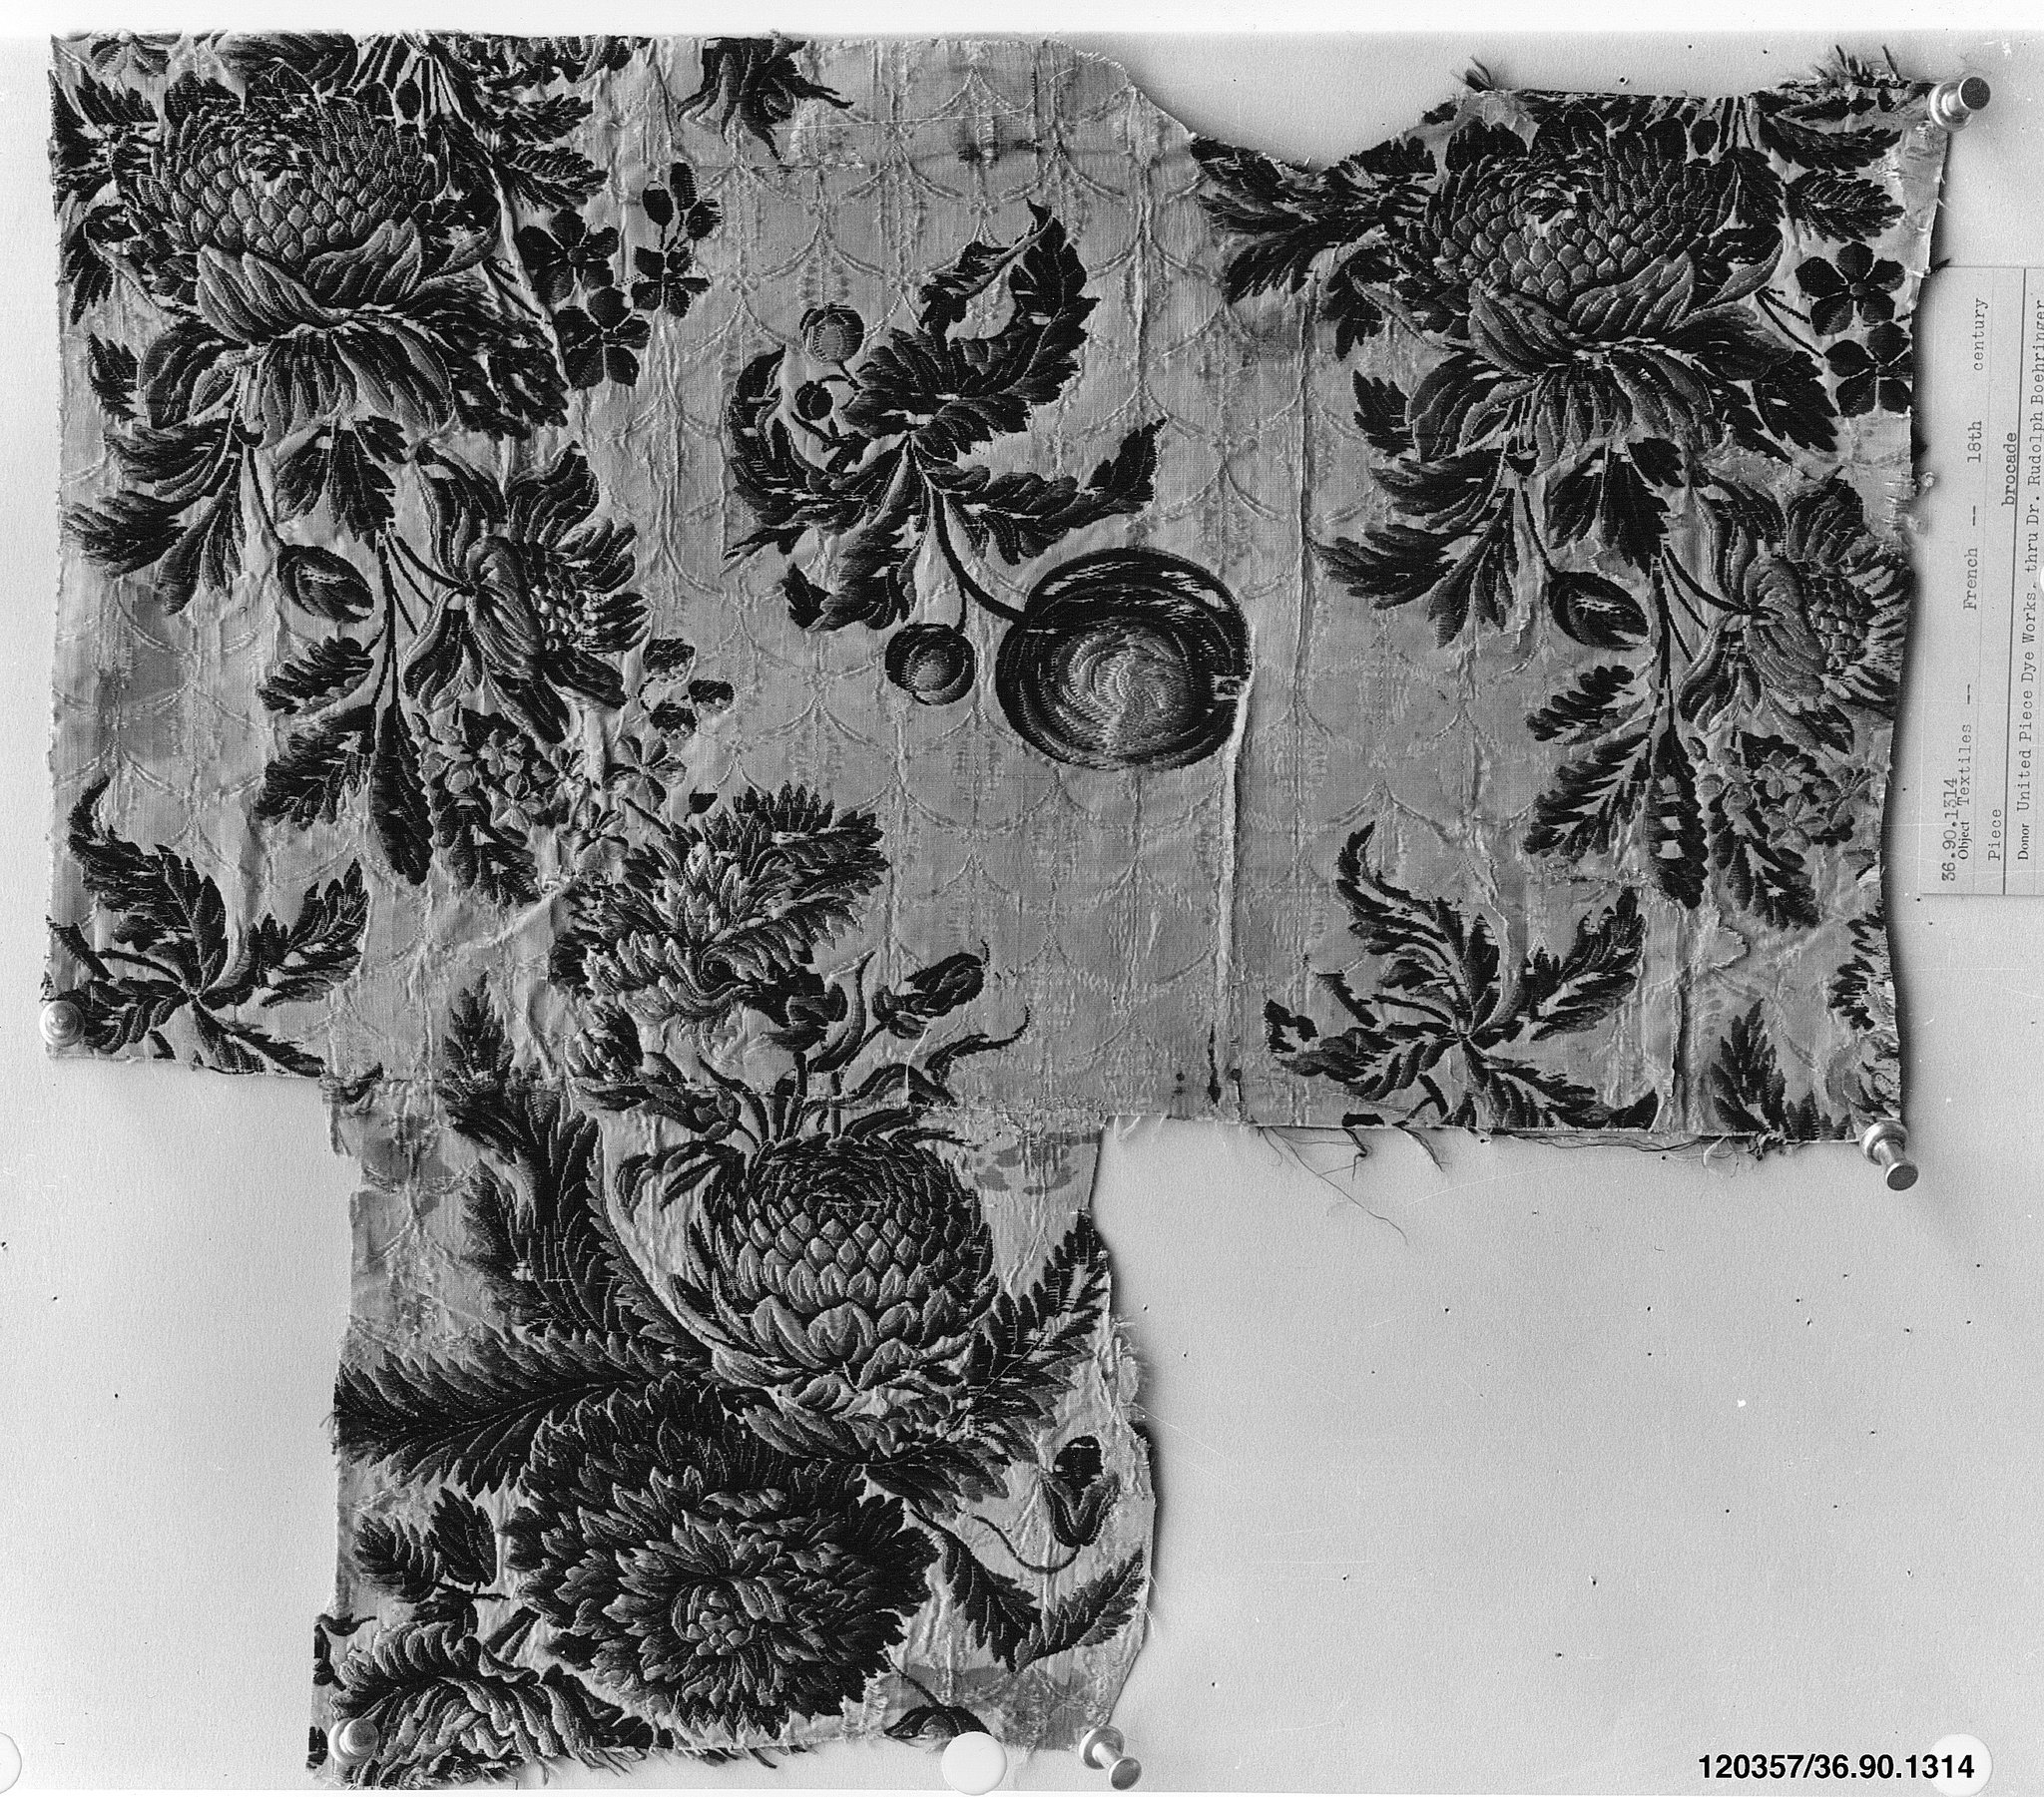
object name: piece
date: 1730-1735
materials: silk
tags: flowers,leaves